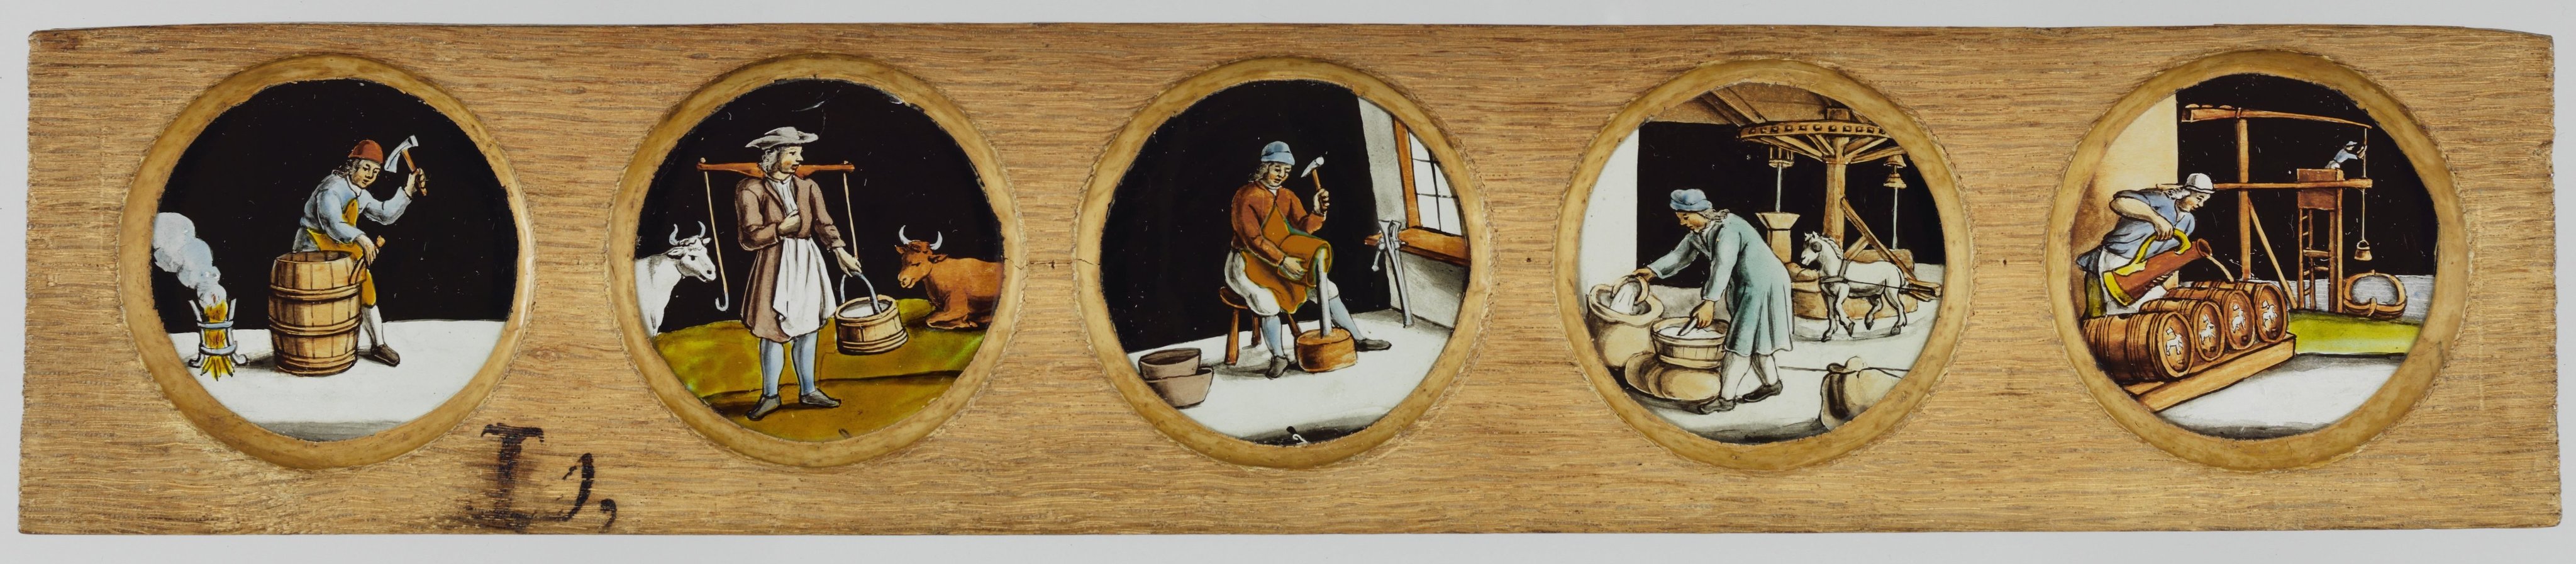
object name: lantern slide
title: Vijf beroepen naar Het menselyk bedryf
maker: Anonymous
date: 1700-1790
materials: glass, wood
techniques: painted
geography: netherlands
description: Vijf glaasjes met uitbeeldingen van beroepen in een houten vatting. Uiterst links: een kuiper brengt met een kuipershamer hoepen aan. Rechts daarvan: de landman (boer), temidden van koeien, over zijn schouders een juk met aan één haak een emmer. In het midden: de koperslager, met een hamer aan het werk bij het raam. Rechts daarvan: de gruttenmaker bij twee gevulde zakken, op de achtergrond een paardemolen. Uiterst rechts: een brouwer vult vaten af, op de achtergrond een kraan om deze in boten te laden.